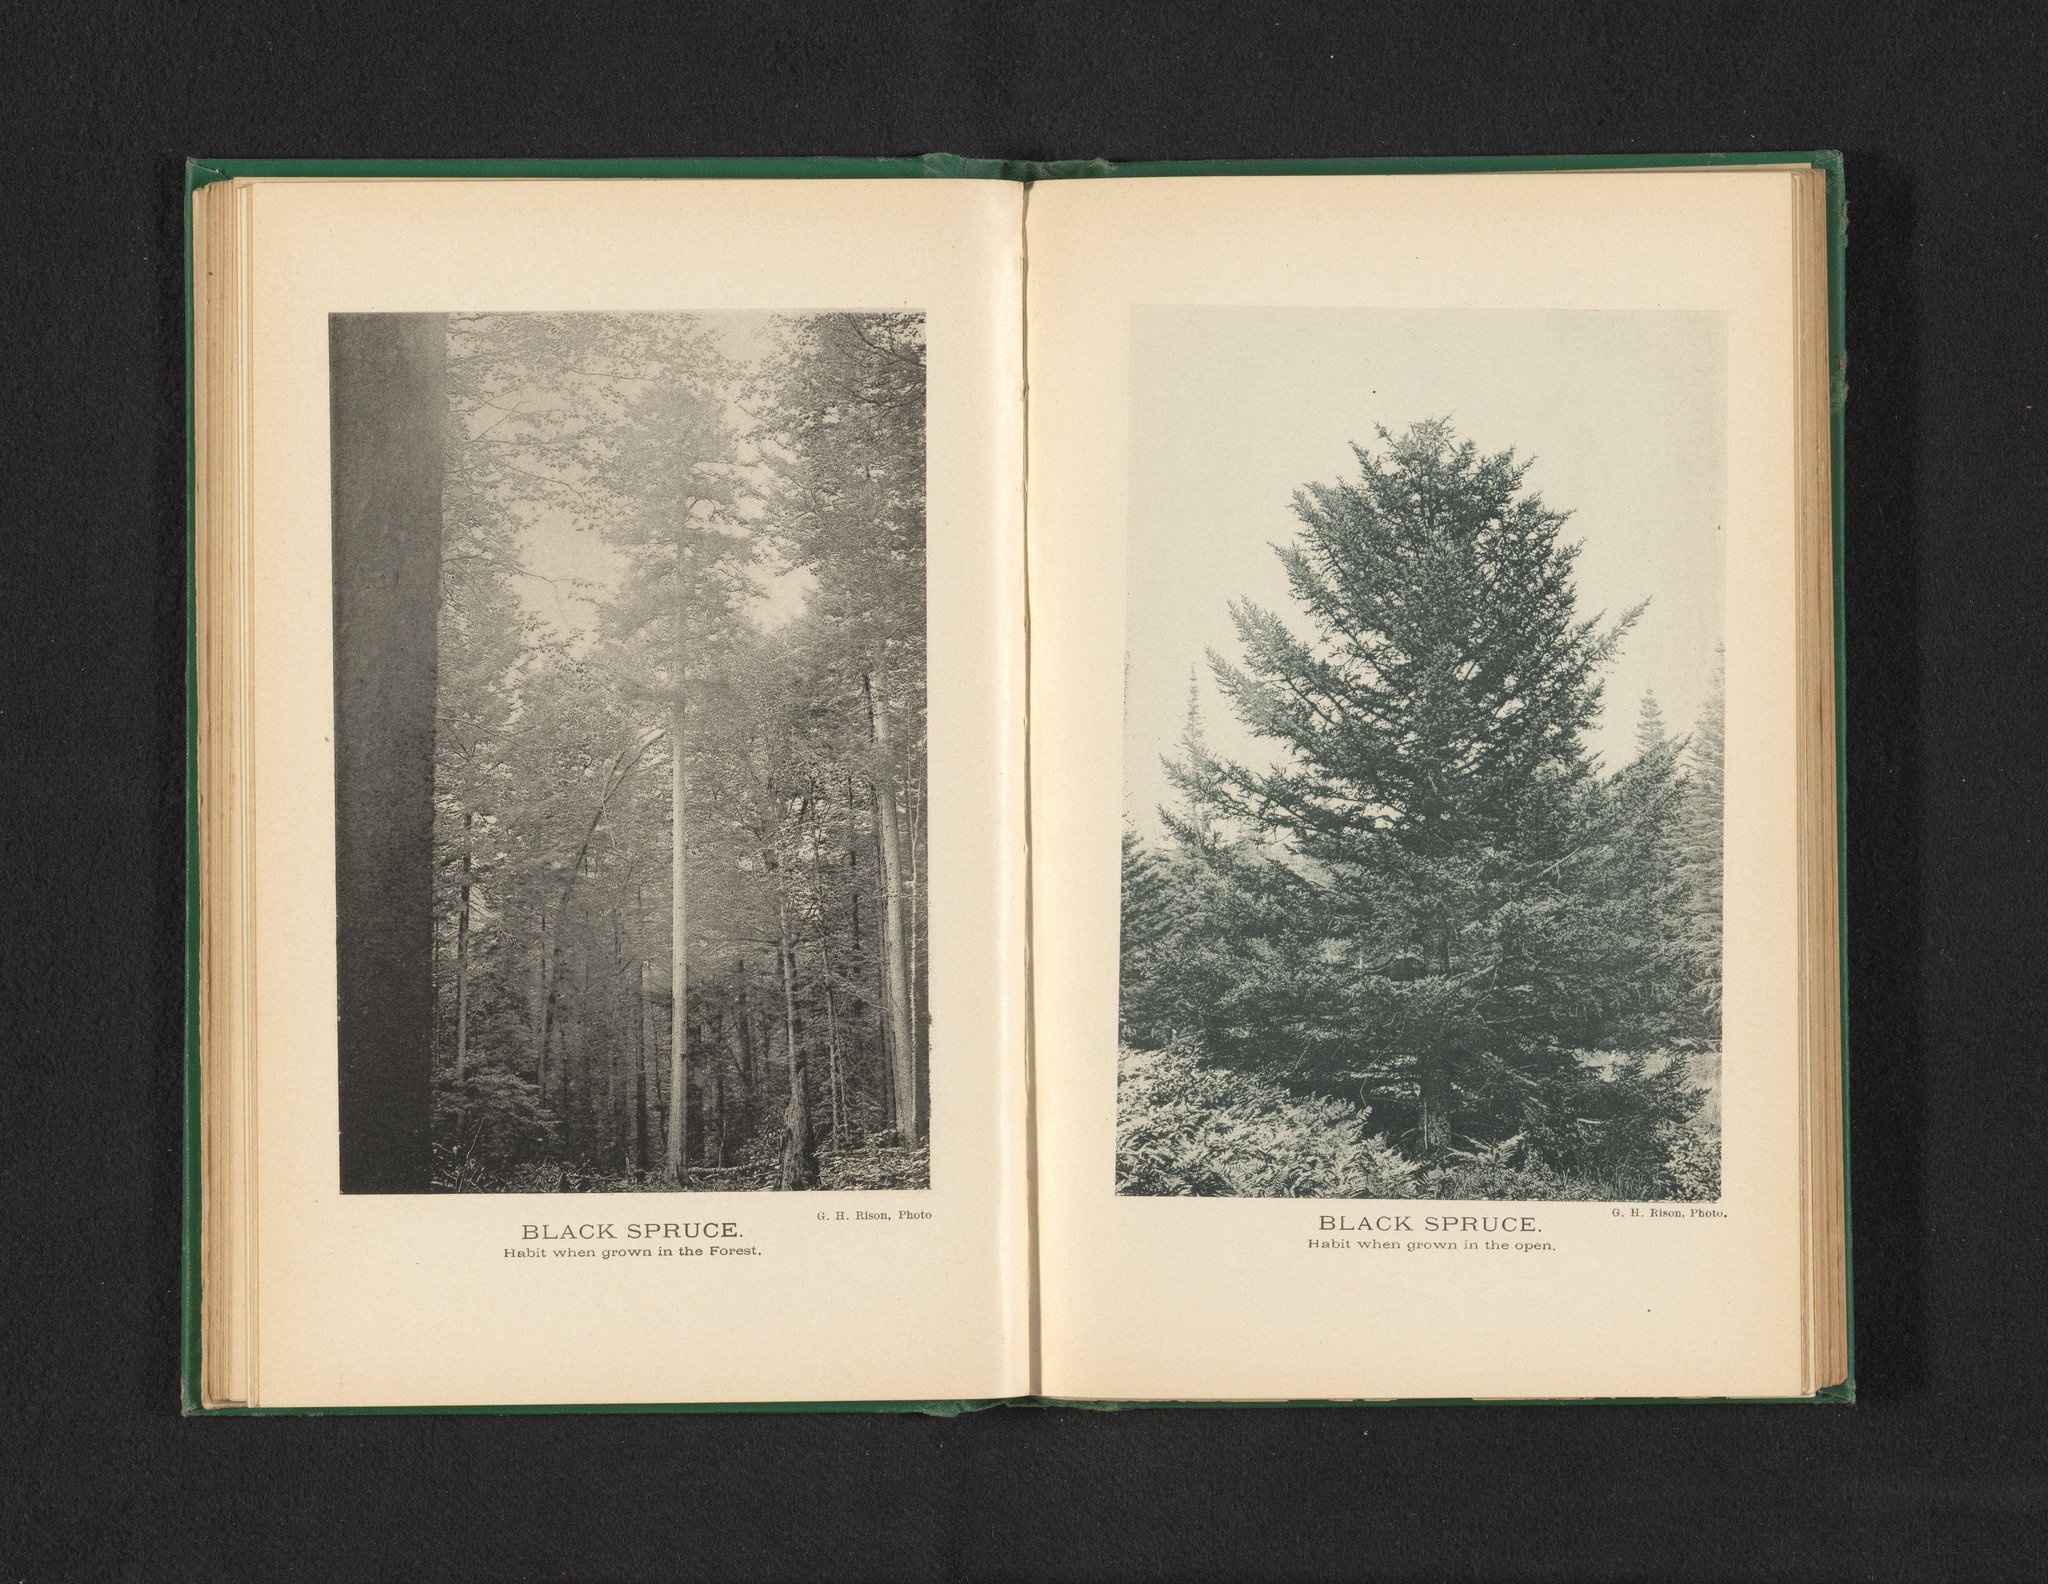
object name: photomechanical print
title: Black spruce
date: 1894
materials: paper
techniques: photograph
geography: new york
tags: trees: spruce